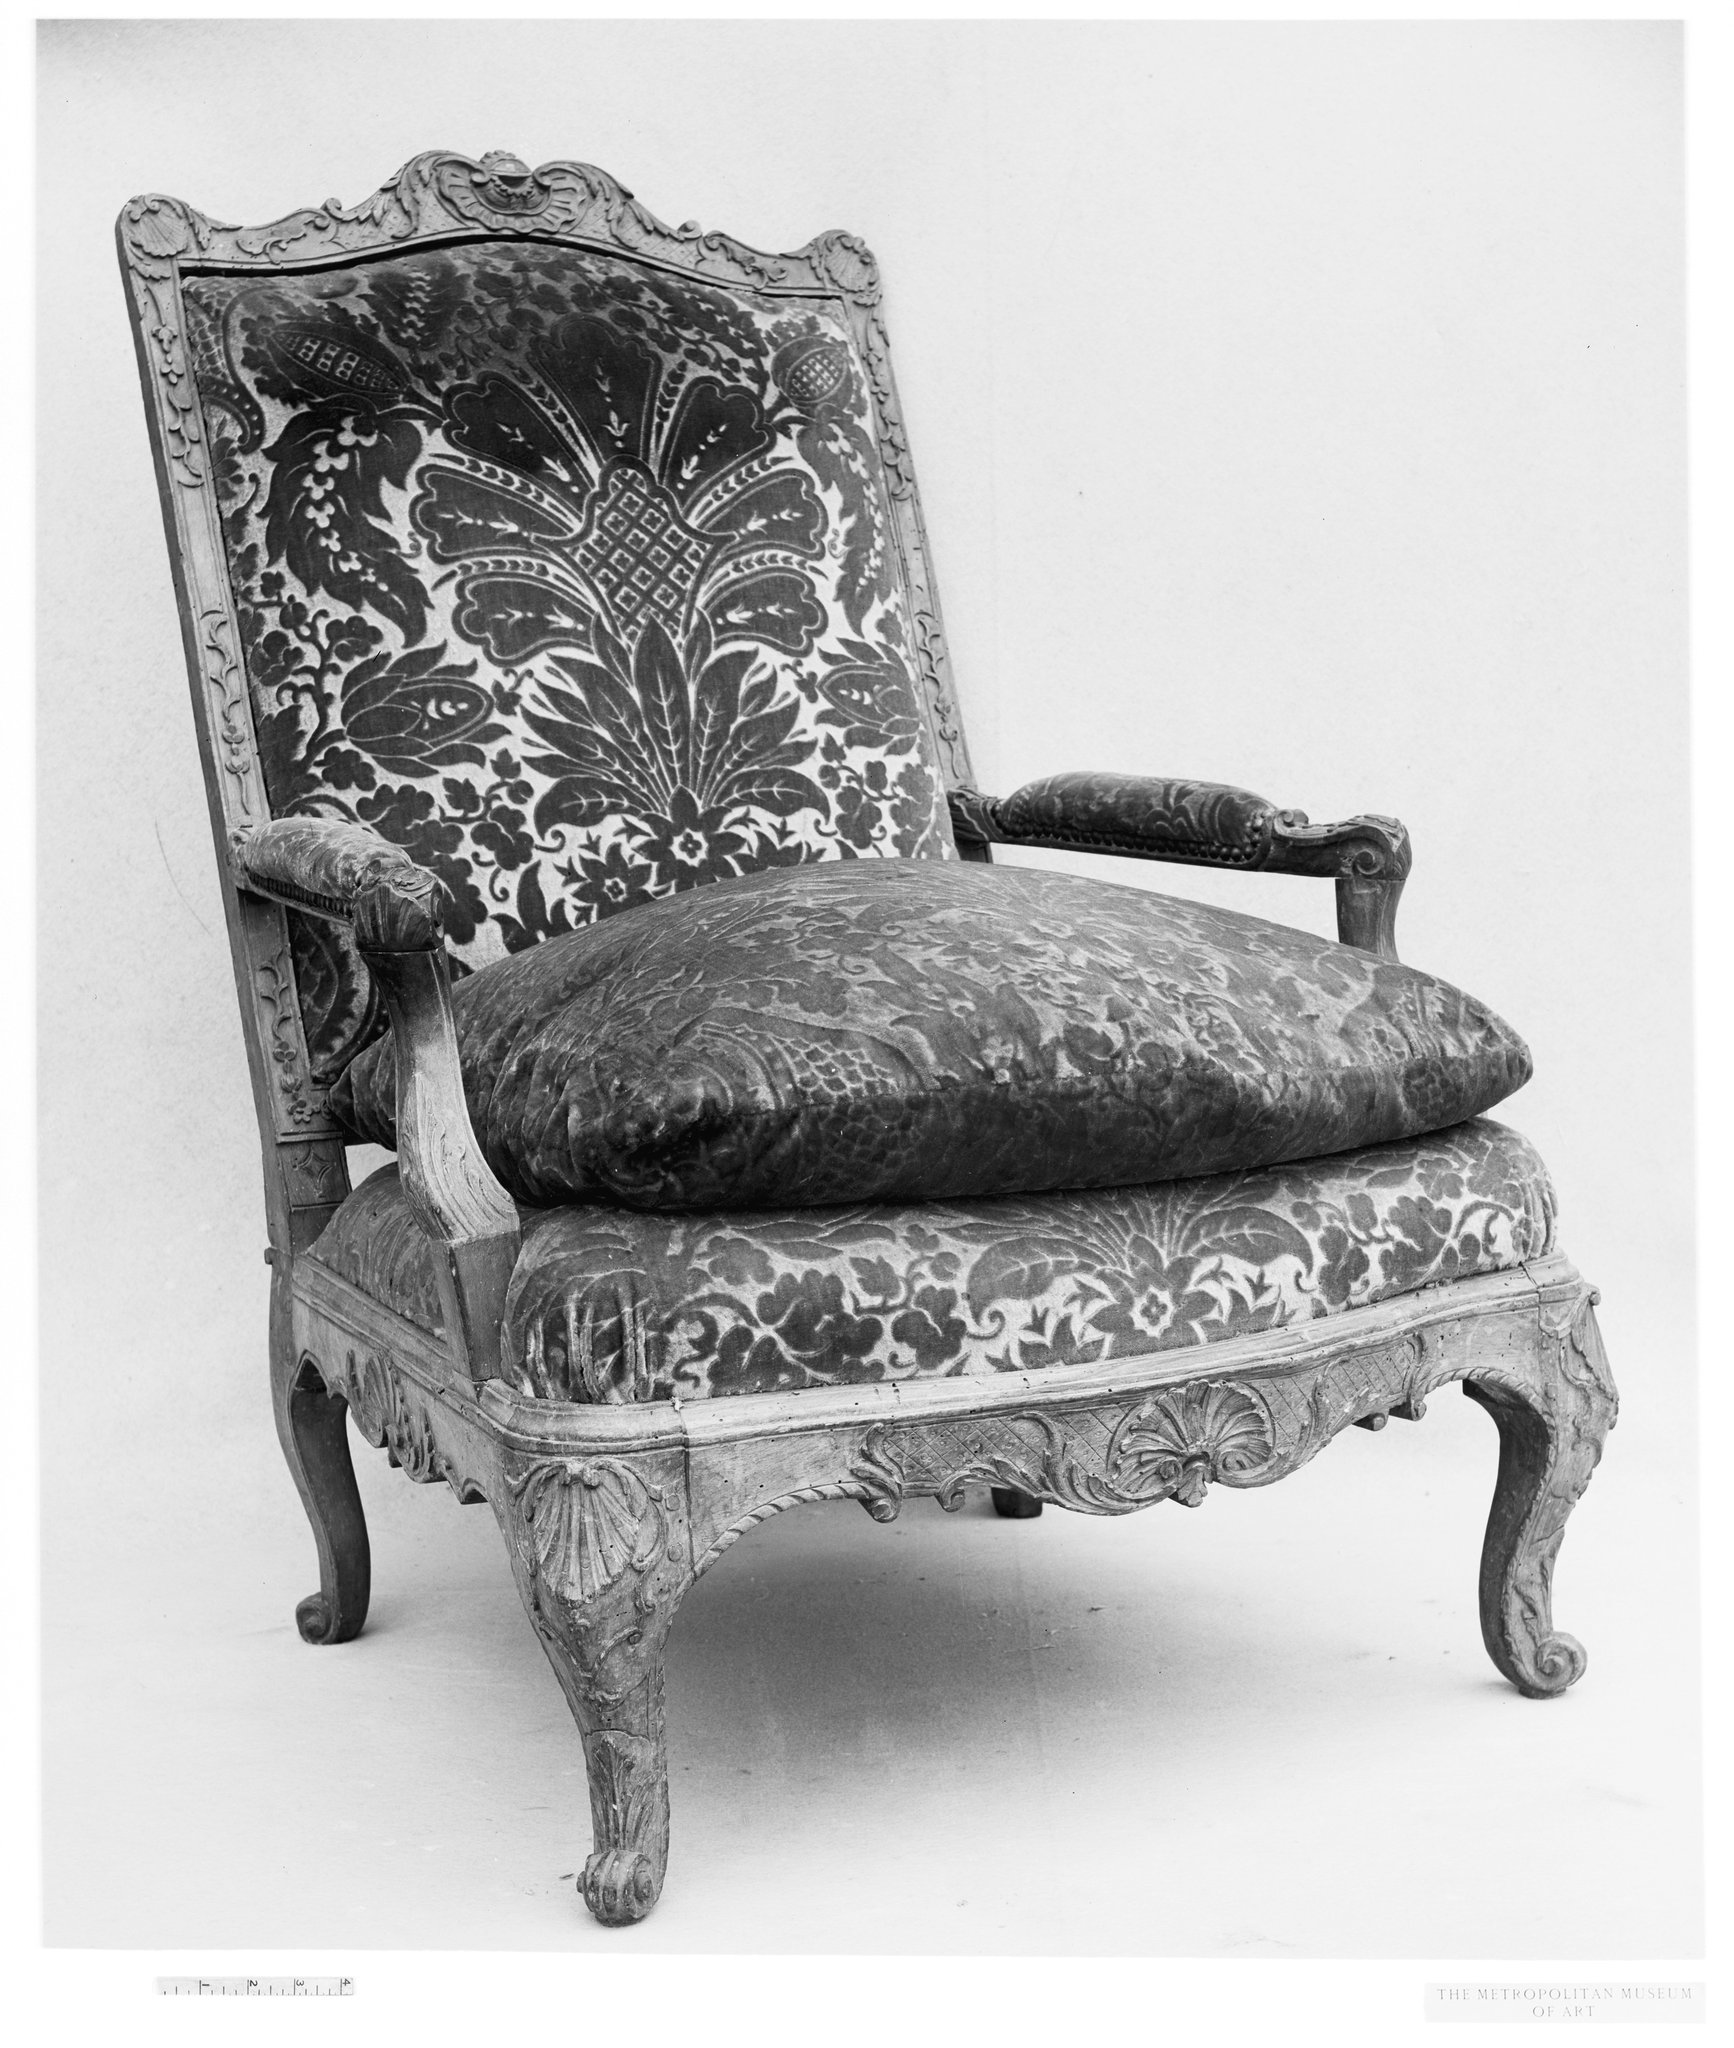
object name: armchair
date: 1701-1725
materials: velvet, wood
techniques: carving